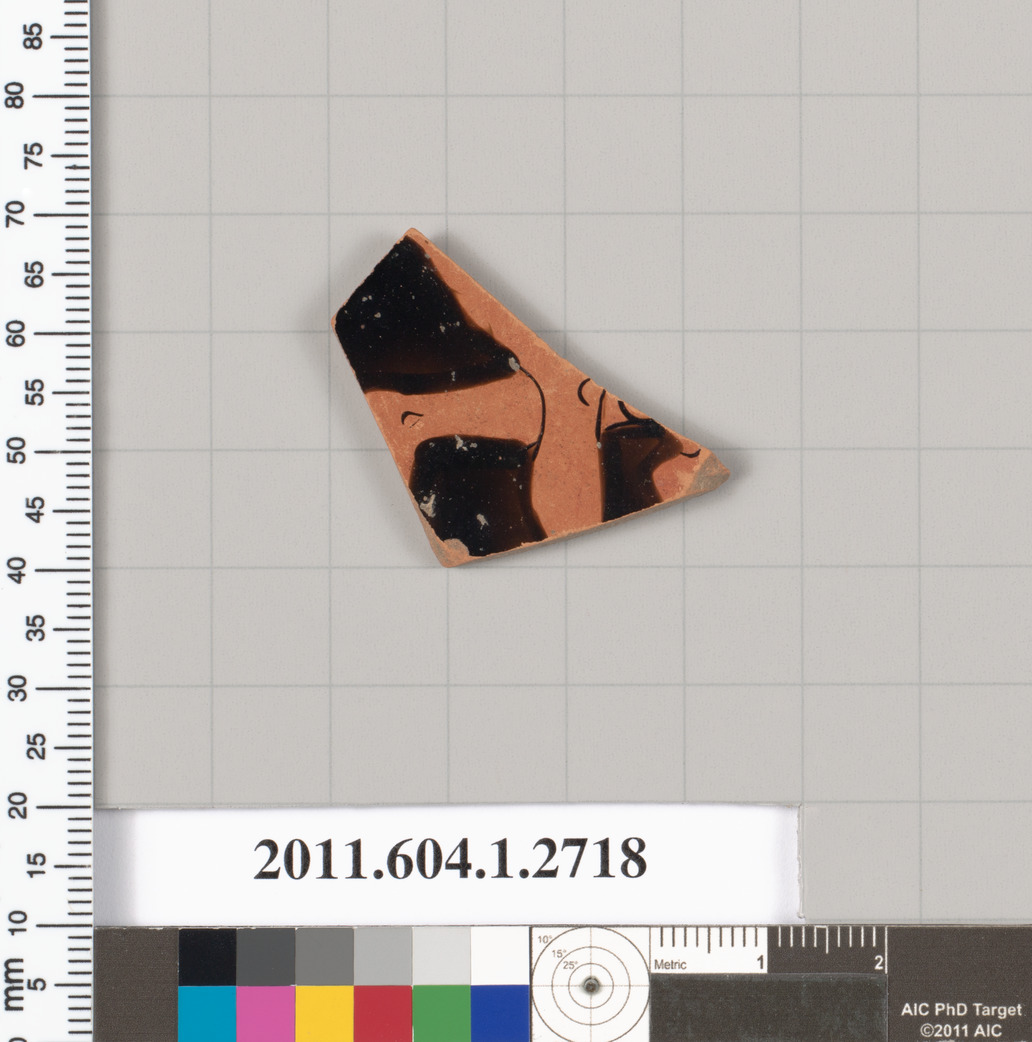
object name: kylix fragment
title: Terracotta fragment of a kylix (drinking cup)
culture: greek, attic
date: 475-451 BCE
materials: terracotta